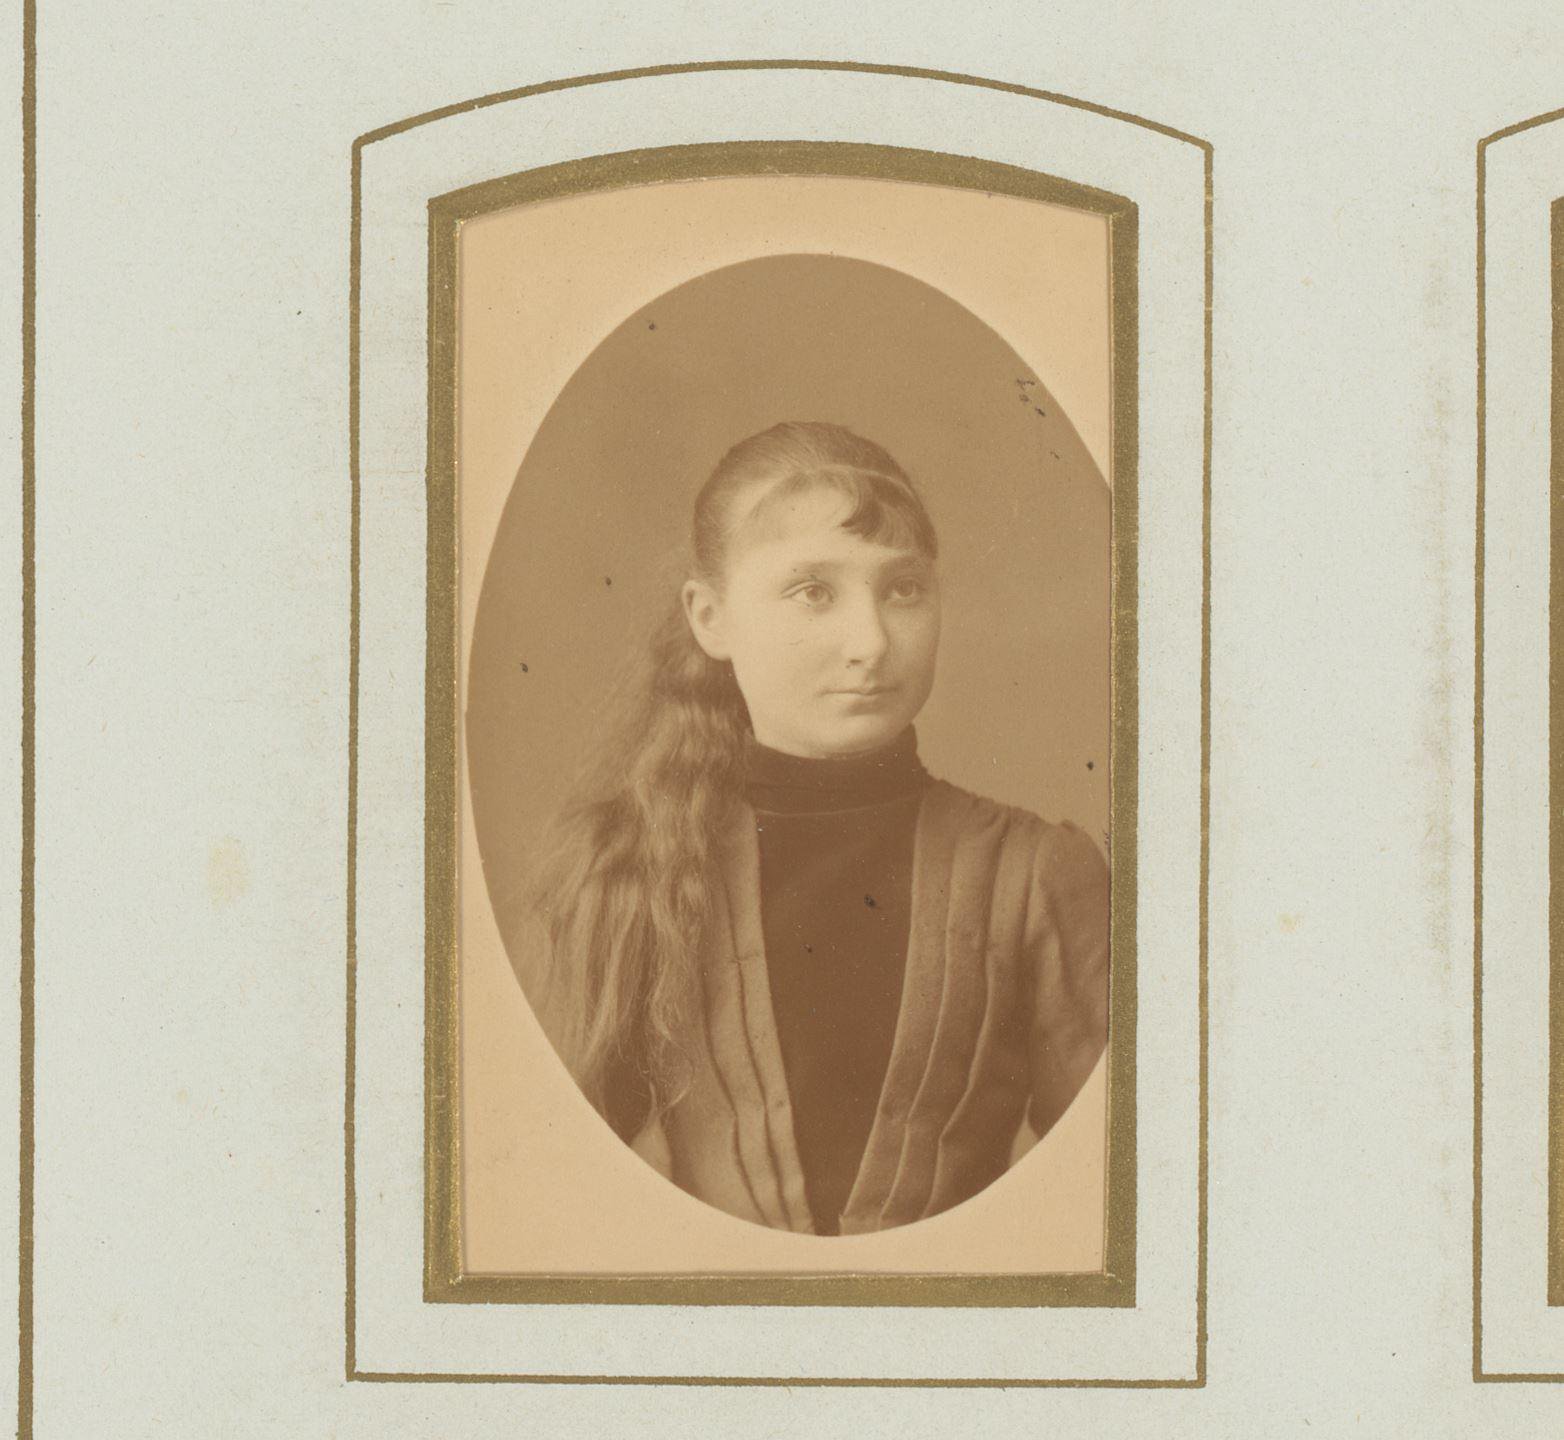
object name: album leaf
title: Portret van een jonge vrouw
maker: albert prouzet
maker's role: fotograaf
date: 1850-1900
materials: cardboard, photographic support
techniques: albumen print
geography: paris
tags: adolescent, young woman, maiden, historical persons - bb - woman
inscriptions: inscription: ‘Photographie/ Populaire/ &/ PARISIENNE/ A. Prouzet/ LYON/ 7, Rue Duhamel/ PARIS 17, Bd. SÉBASTOPOL/ Tous les Clichés sont conservés’